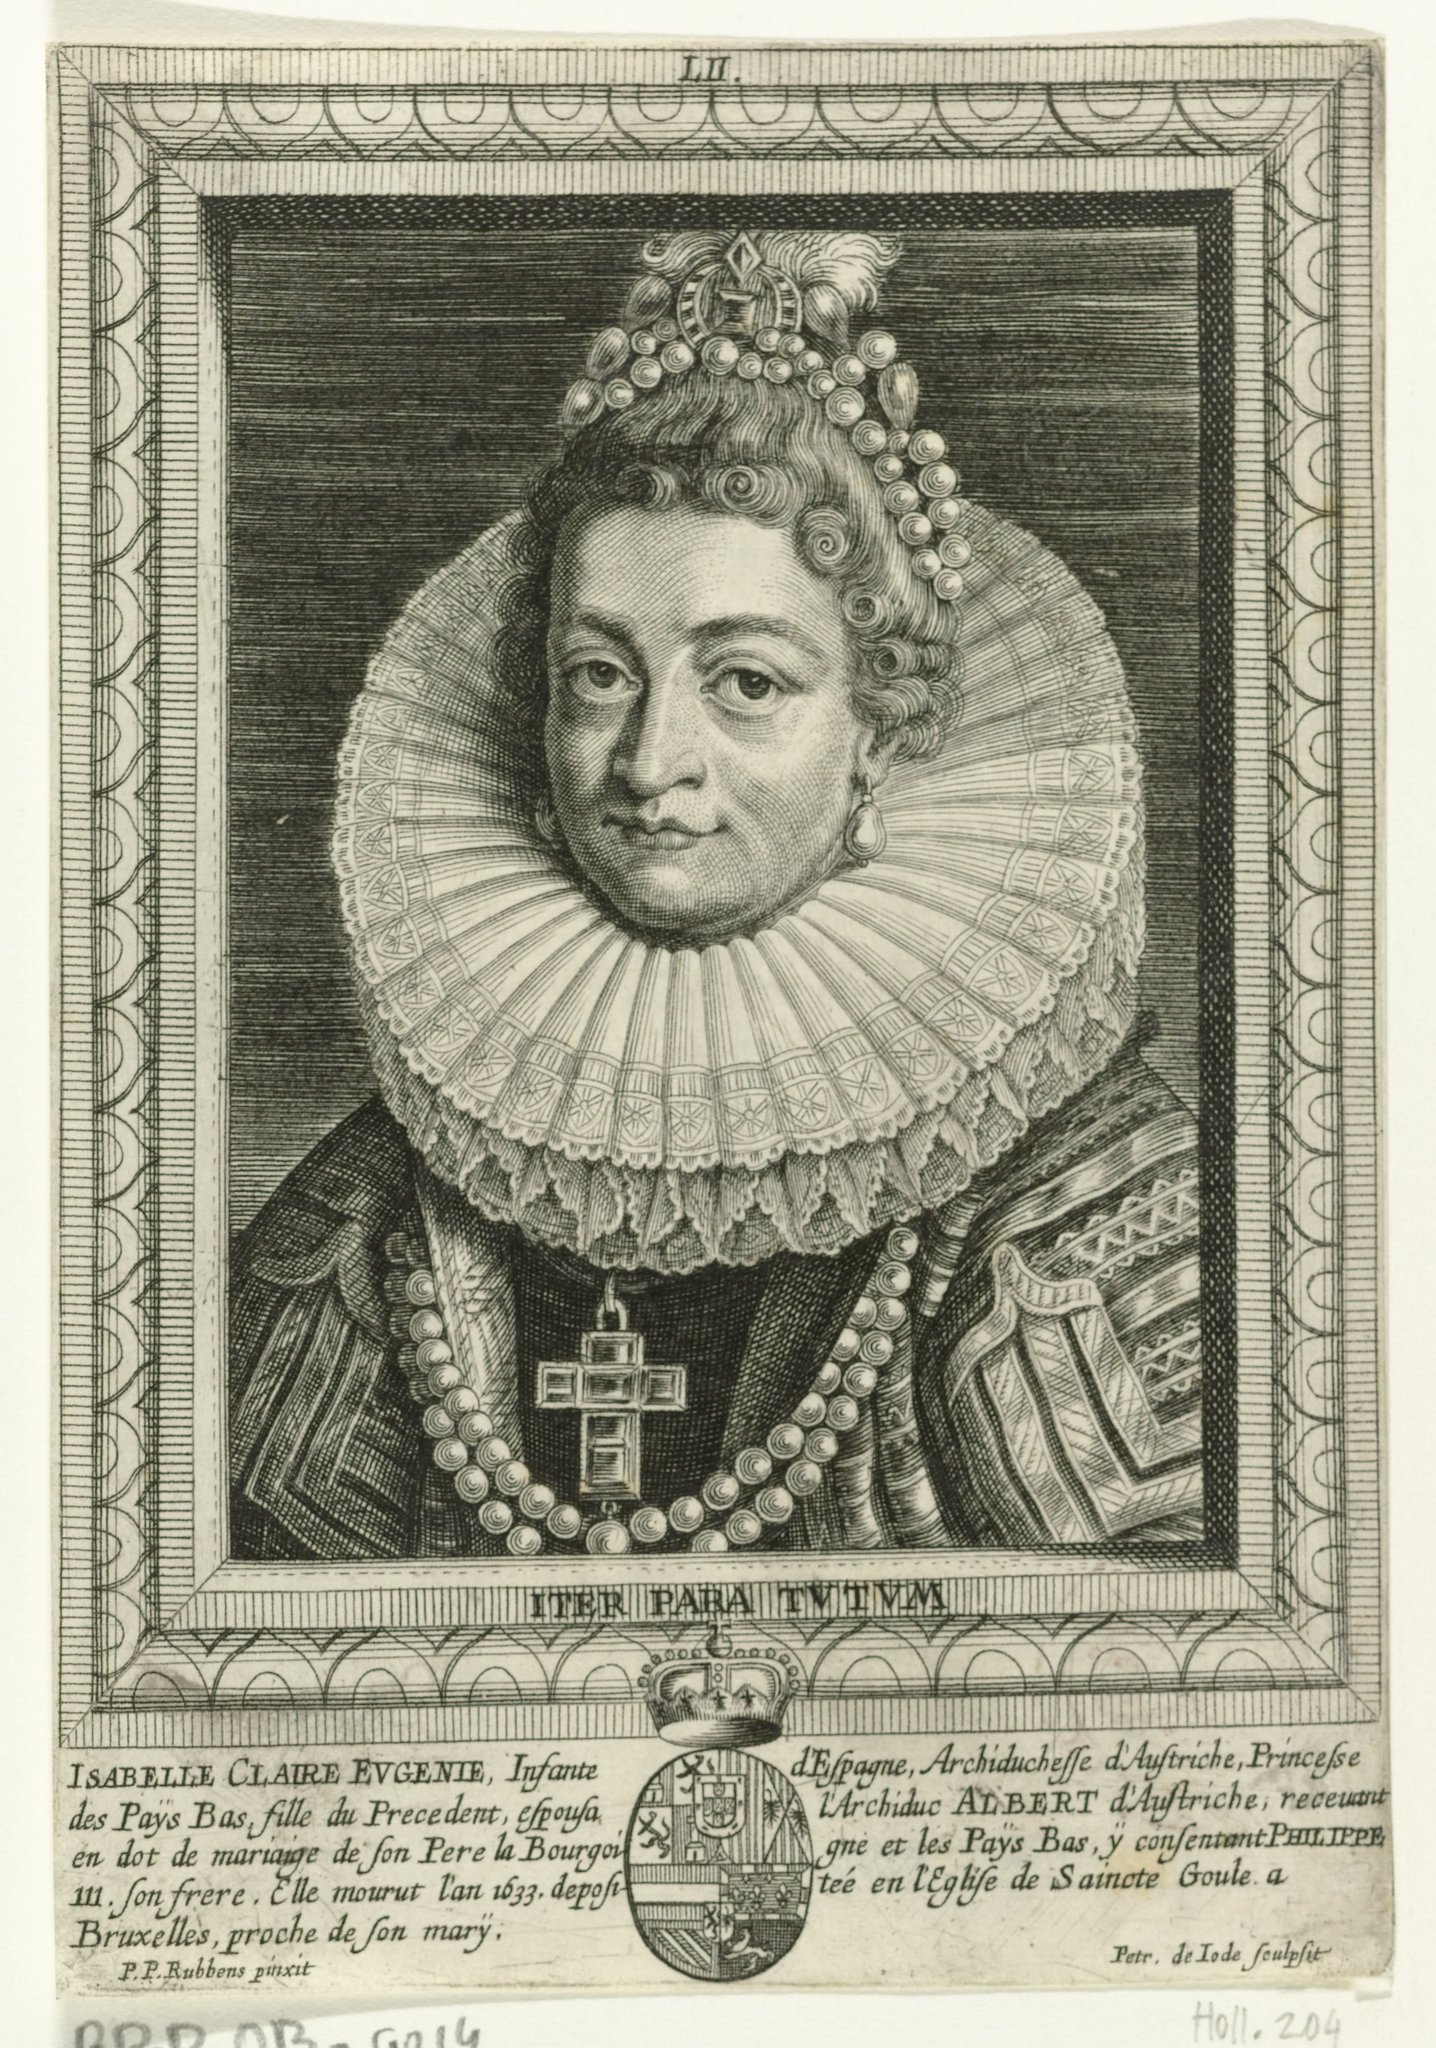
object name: book illustration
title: Portret van Isabella Clara Eugenia, infante van Spanje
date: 1661-1663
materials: paper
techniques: engraving, etching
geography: antwerp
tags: infante van spanje isabella clara eugenia, neck-gear: collar (+ women's clothes), pearl; pearl necklace (+ women's clothes)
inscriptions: collector's mark: Lugt 240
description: Busteportret van Isabella Clara Eugenia, met plooikraag. Haar kapsel is versierd met parels en edelstenen. Het portret is gevat in een rechthoekige omlijsting met een motto in het Latijn. In de marge het wapenschild van de geportretteerde en een vijfregelig onderschrift in het Frans. Prent uit een boek waarin 54 prenten met portretten.